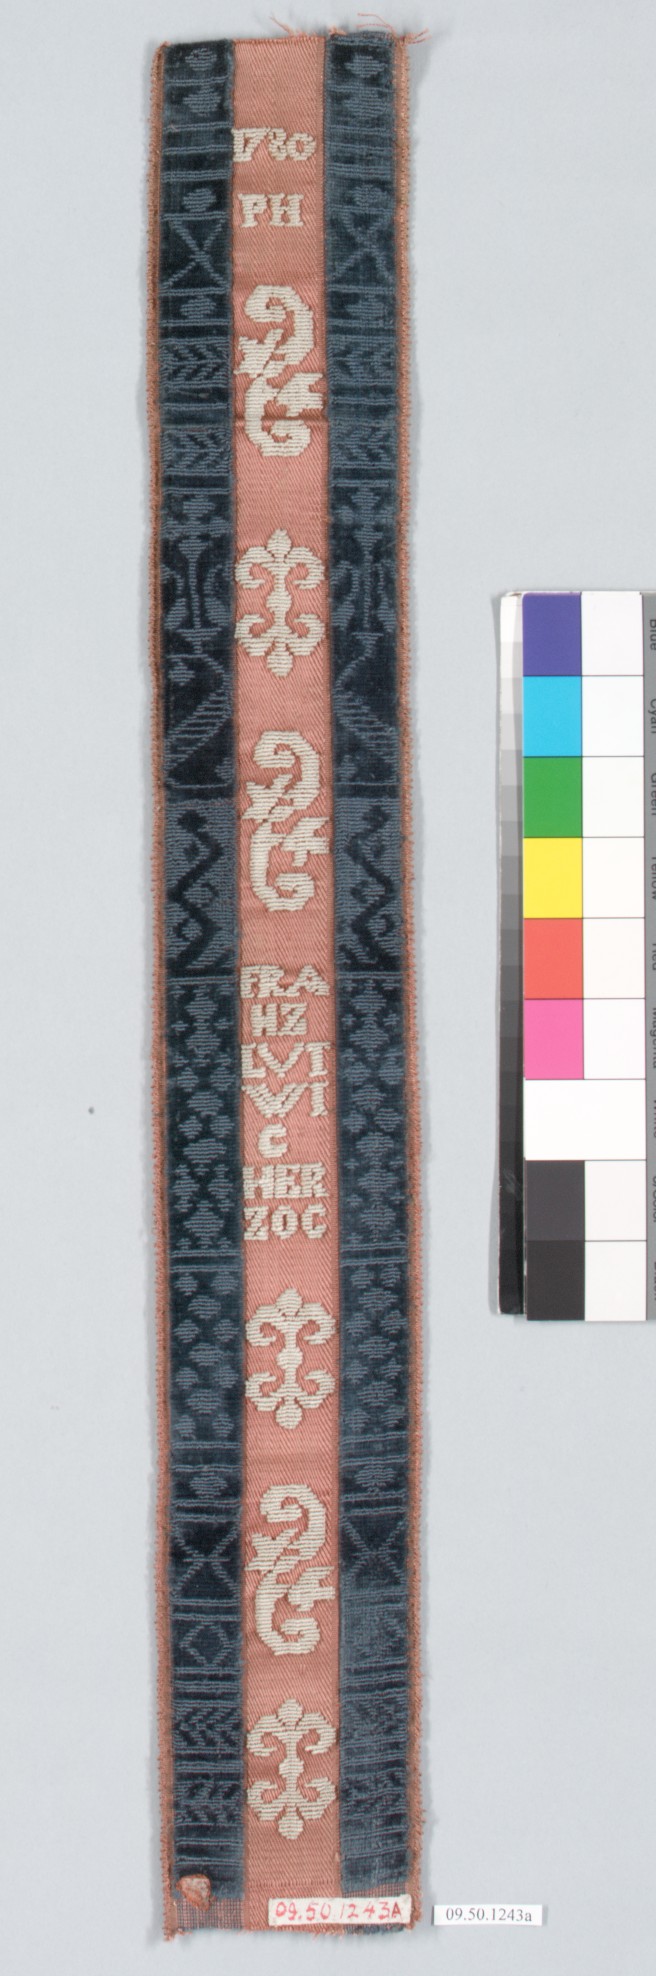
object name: galloon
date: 1701-1800